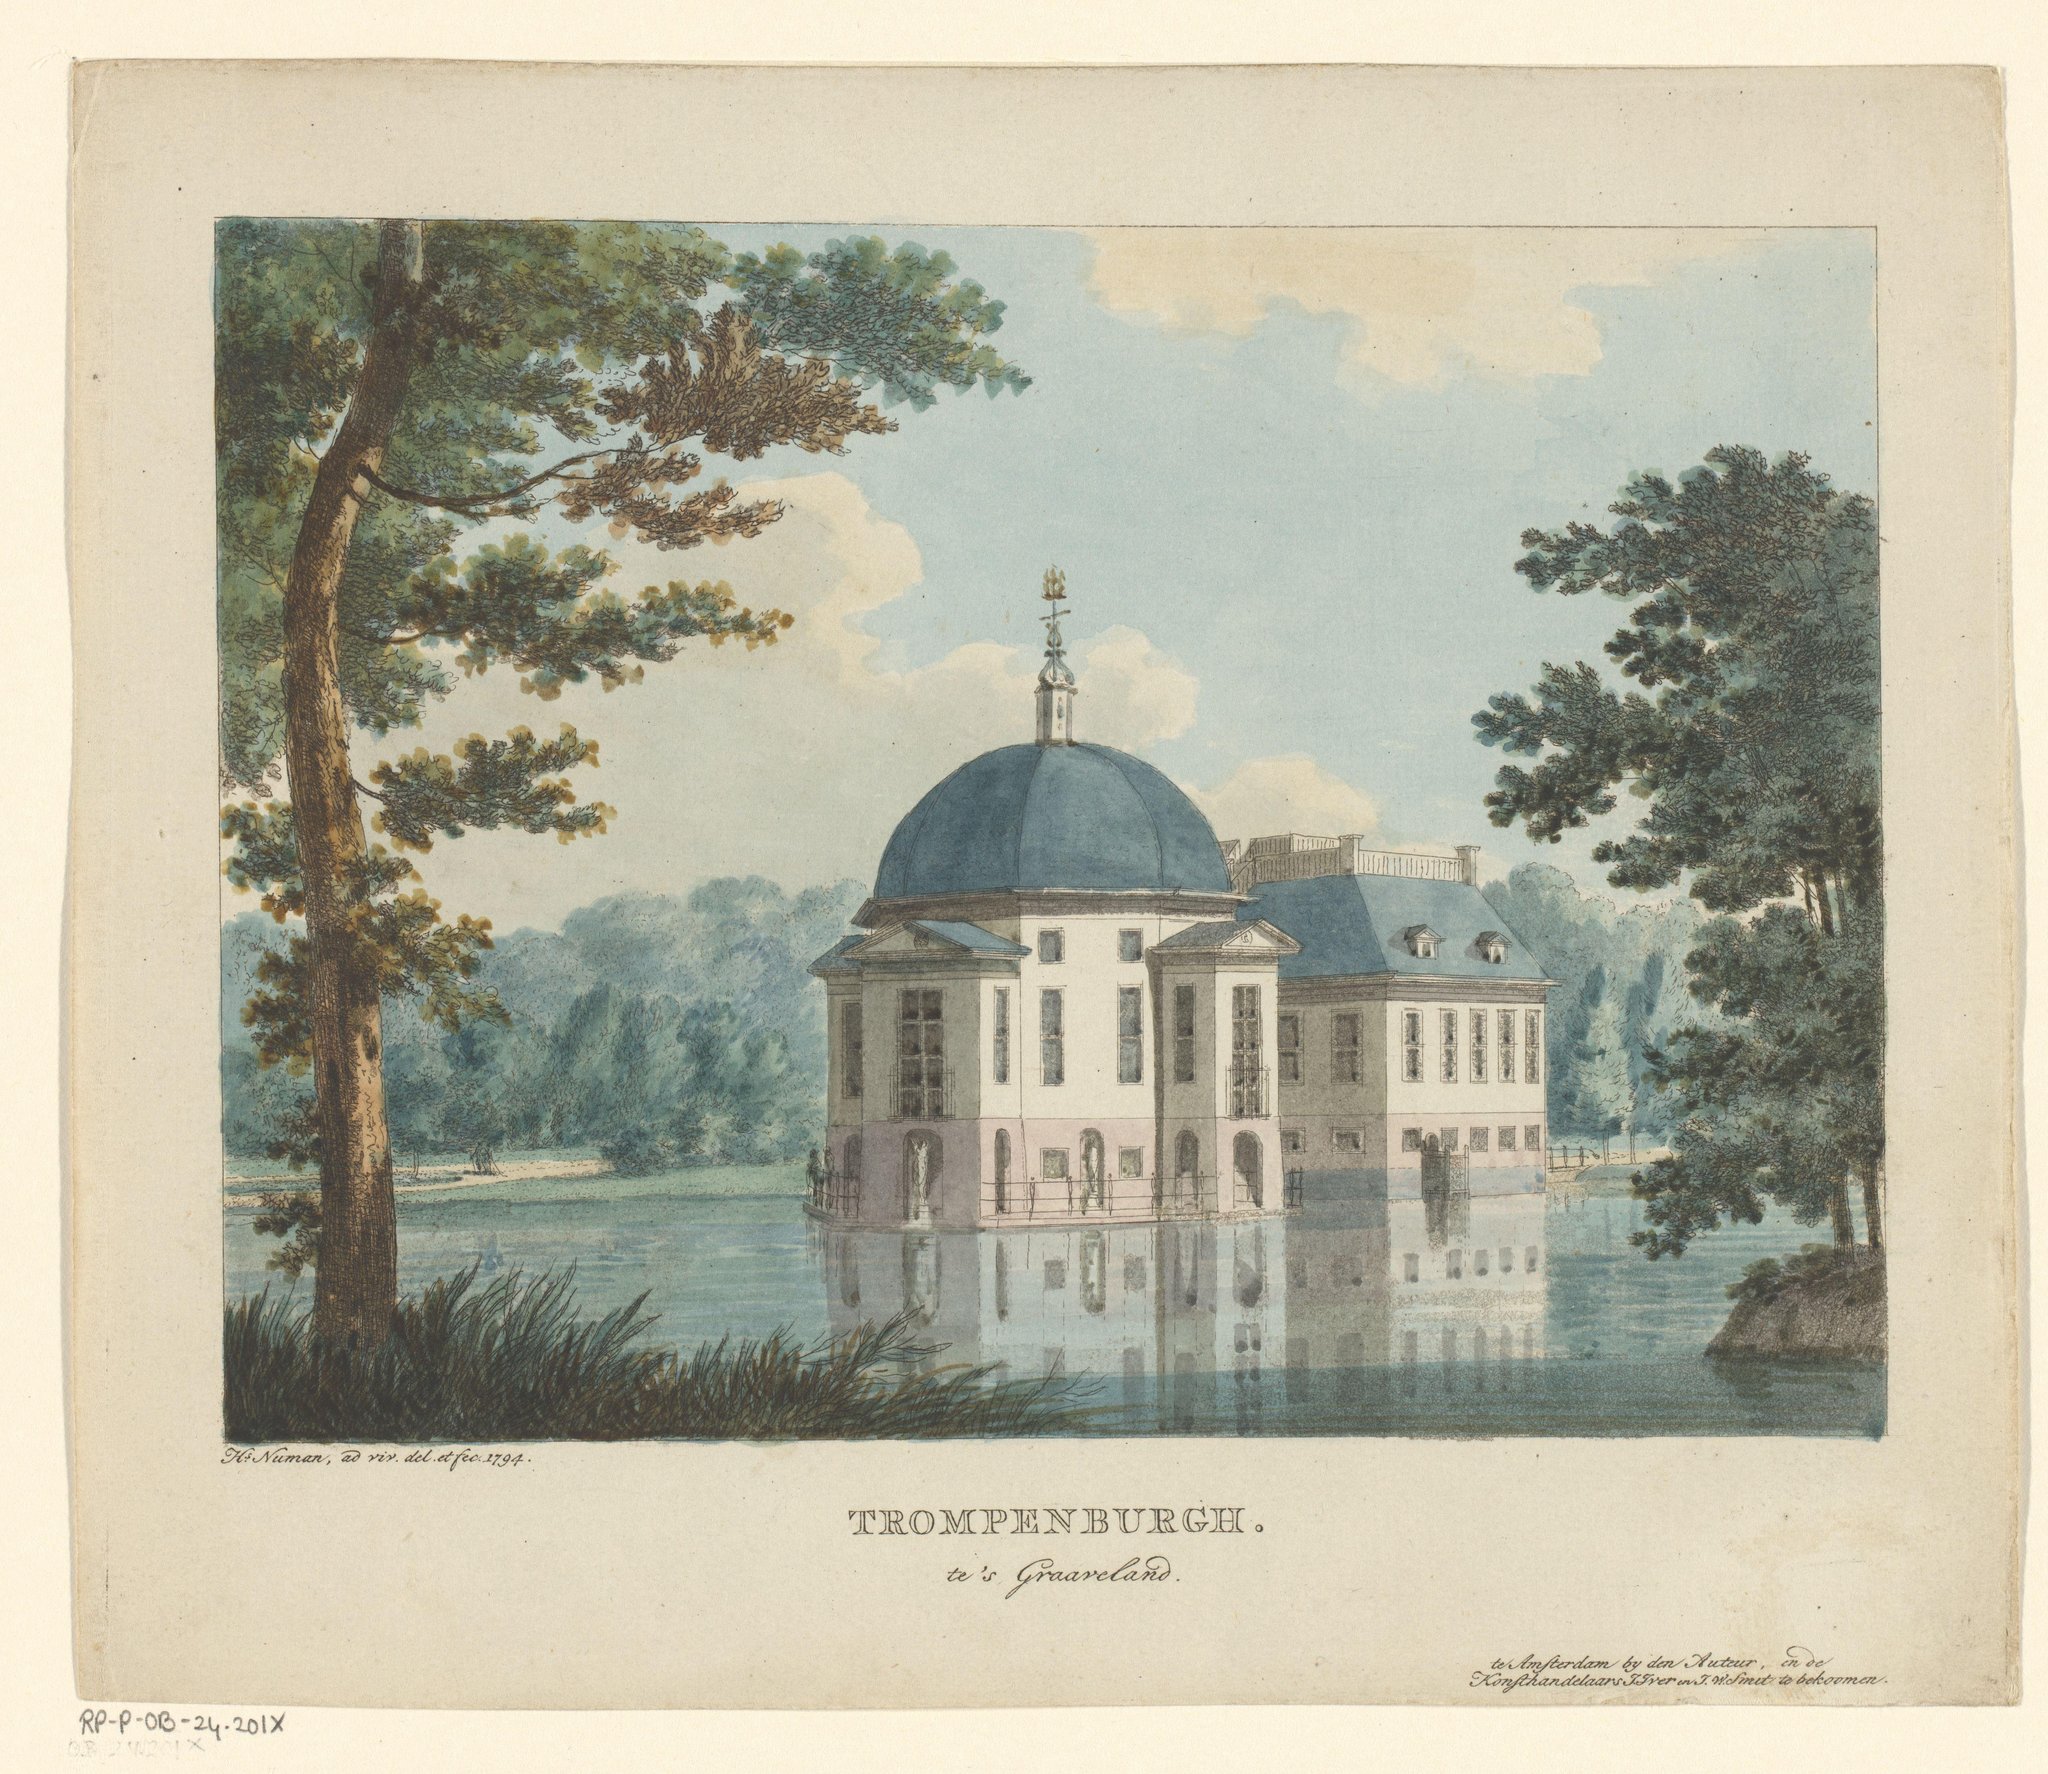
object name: print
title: Trompenburgh te 's Graaveland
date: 1794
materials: paper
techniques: etching, hand coloring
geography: amsterdam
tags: country-house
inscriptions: collector's mark: Lugt 2166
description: Prent gebruikt in: Numan, Hermanus. Vierentwintig printtekeningen met couleuren, verbeeldende Hollandsche buitenplaatzen. Amsterdam: Jan IJver, Jan Willem Smit en Hermanus Numan, 1797.